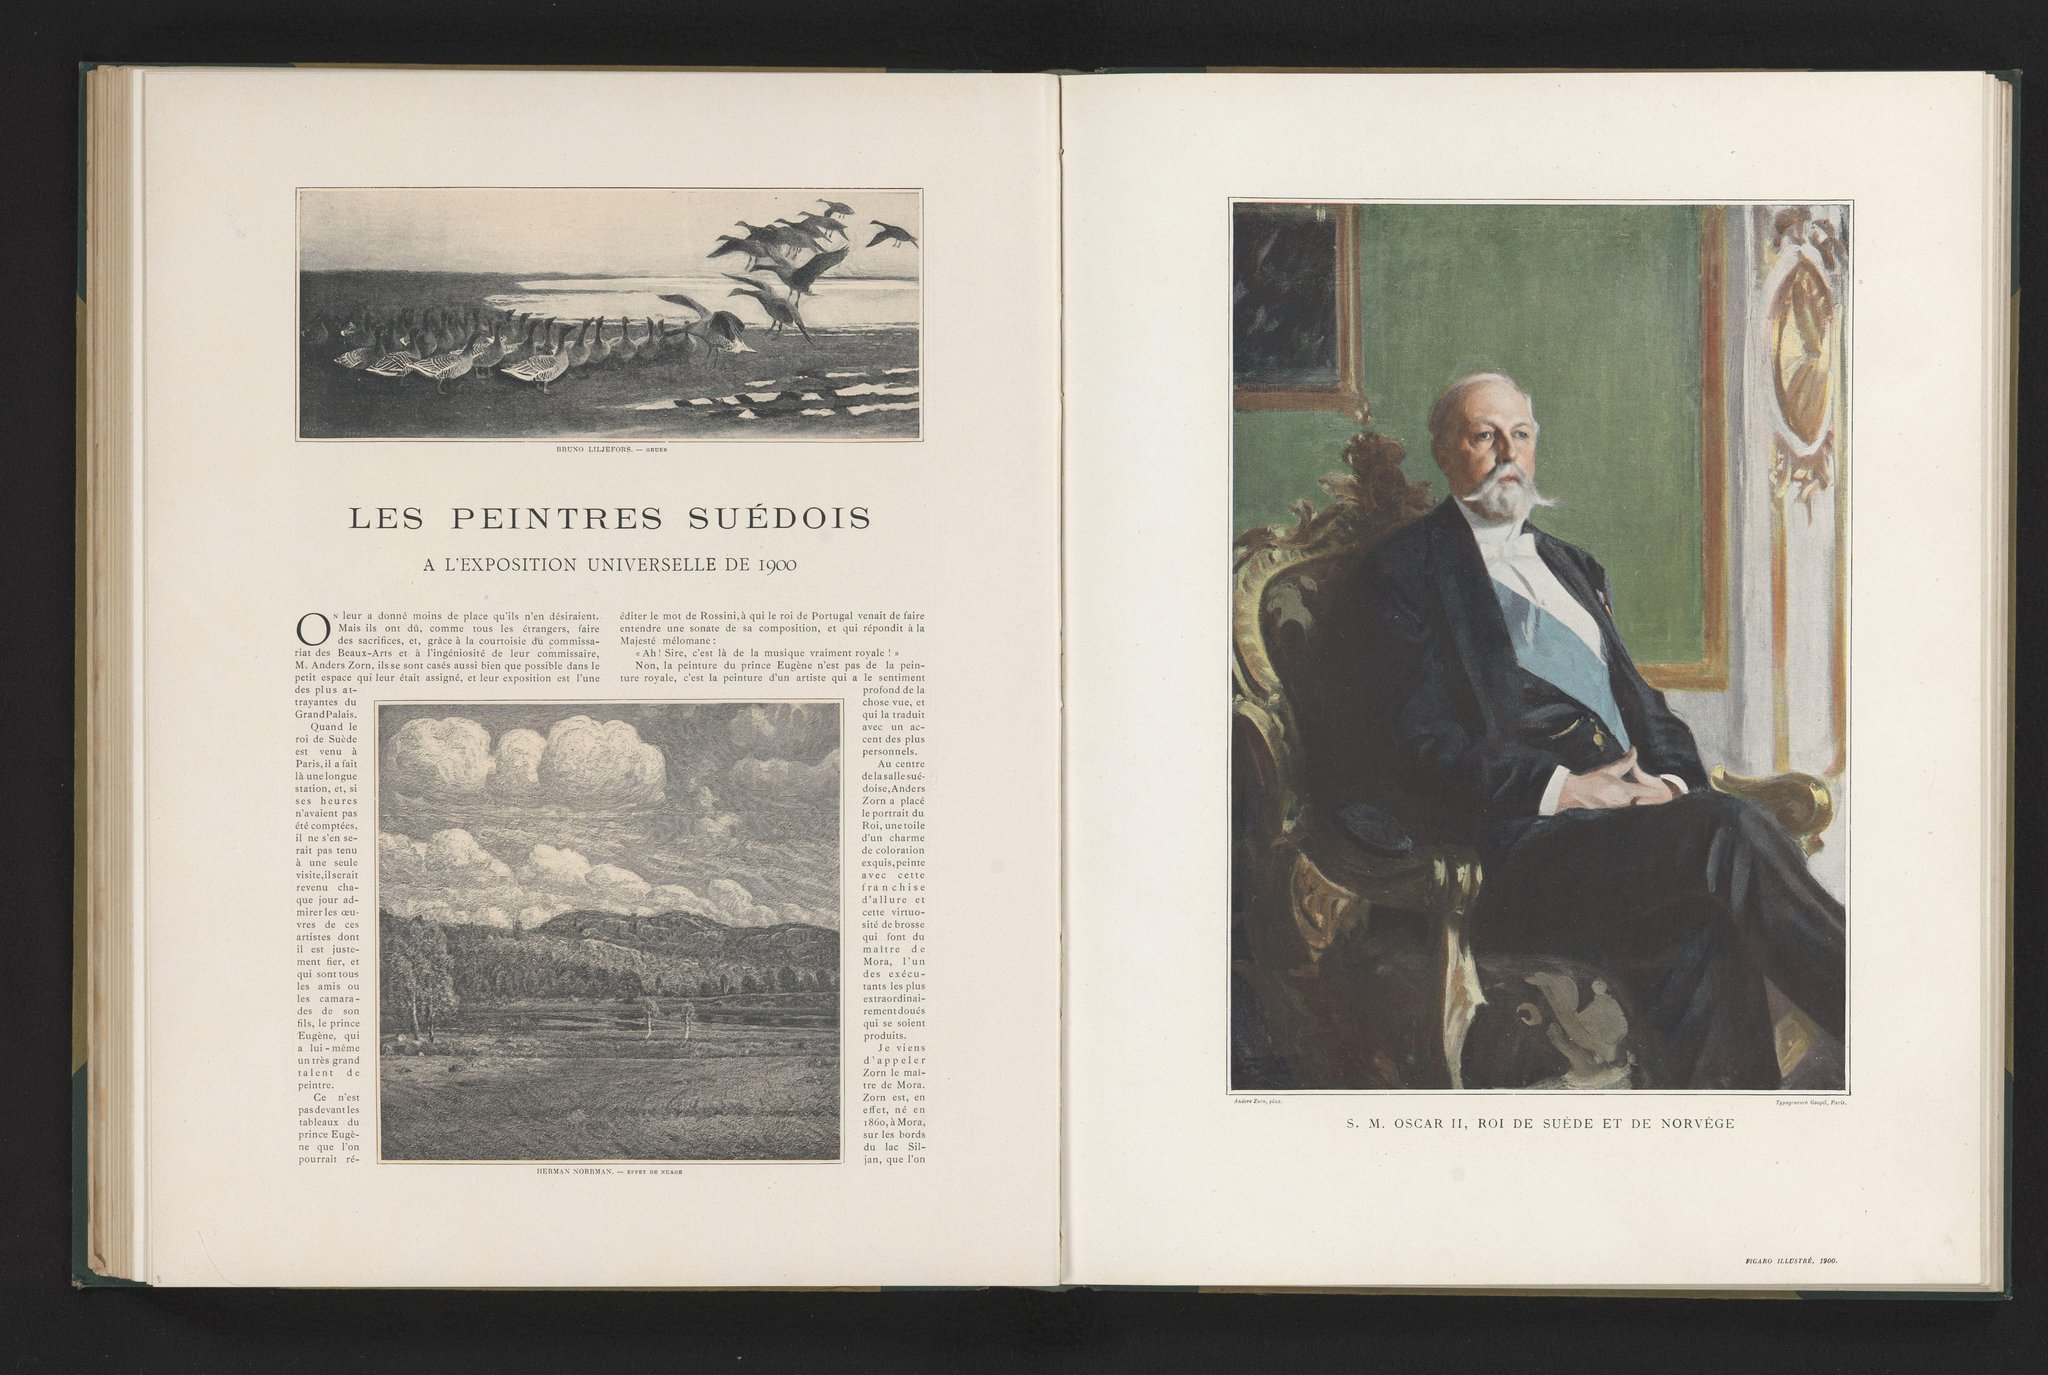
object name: page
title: Reproductie van een geschilderd portret van Oscar II, koning van Zweden en Noorwegen door Anders Leonard Zorn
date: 1885-1901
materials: paper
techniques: four-color autotype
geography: paris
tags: world fair, world exhibition, paris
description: Prent tegenover pagina 8 van Figaro-Illustré (Juillet 1900).